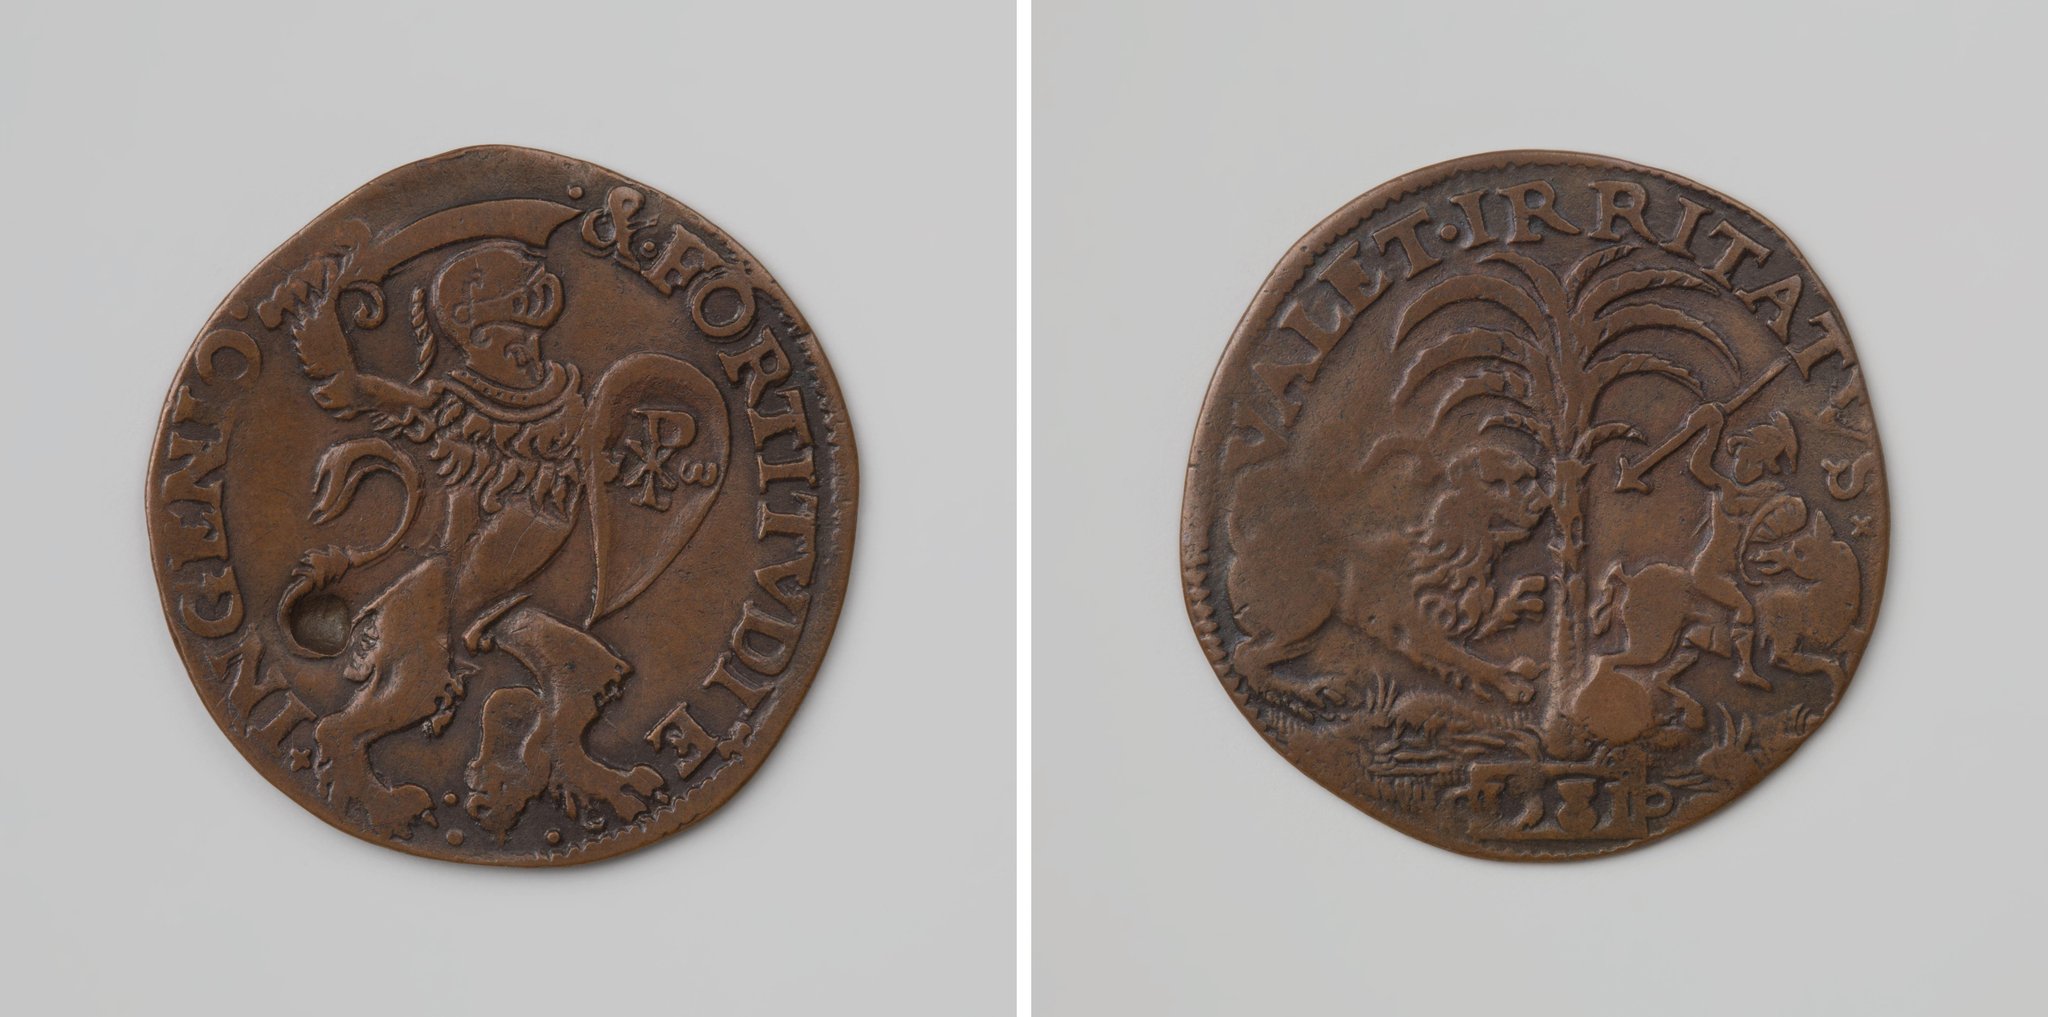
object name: jeton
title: Moedige gedrag der Nederlanders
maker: Anonymous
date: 1581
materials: copper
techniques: striking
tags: tachtigjarige oorlog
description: Koperen penning. Voorzijde: gehelmde leeuw met zwaard en schild met XP-monogram binnen omschrift. Keerzijde: ruiter met speer in hand valt leeuw aan, die zich achter palmboom verschuilt boven cartouche met jaartal binnen omschrift.